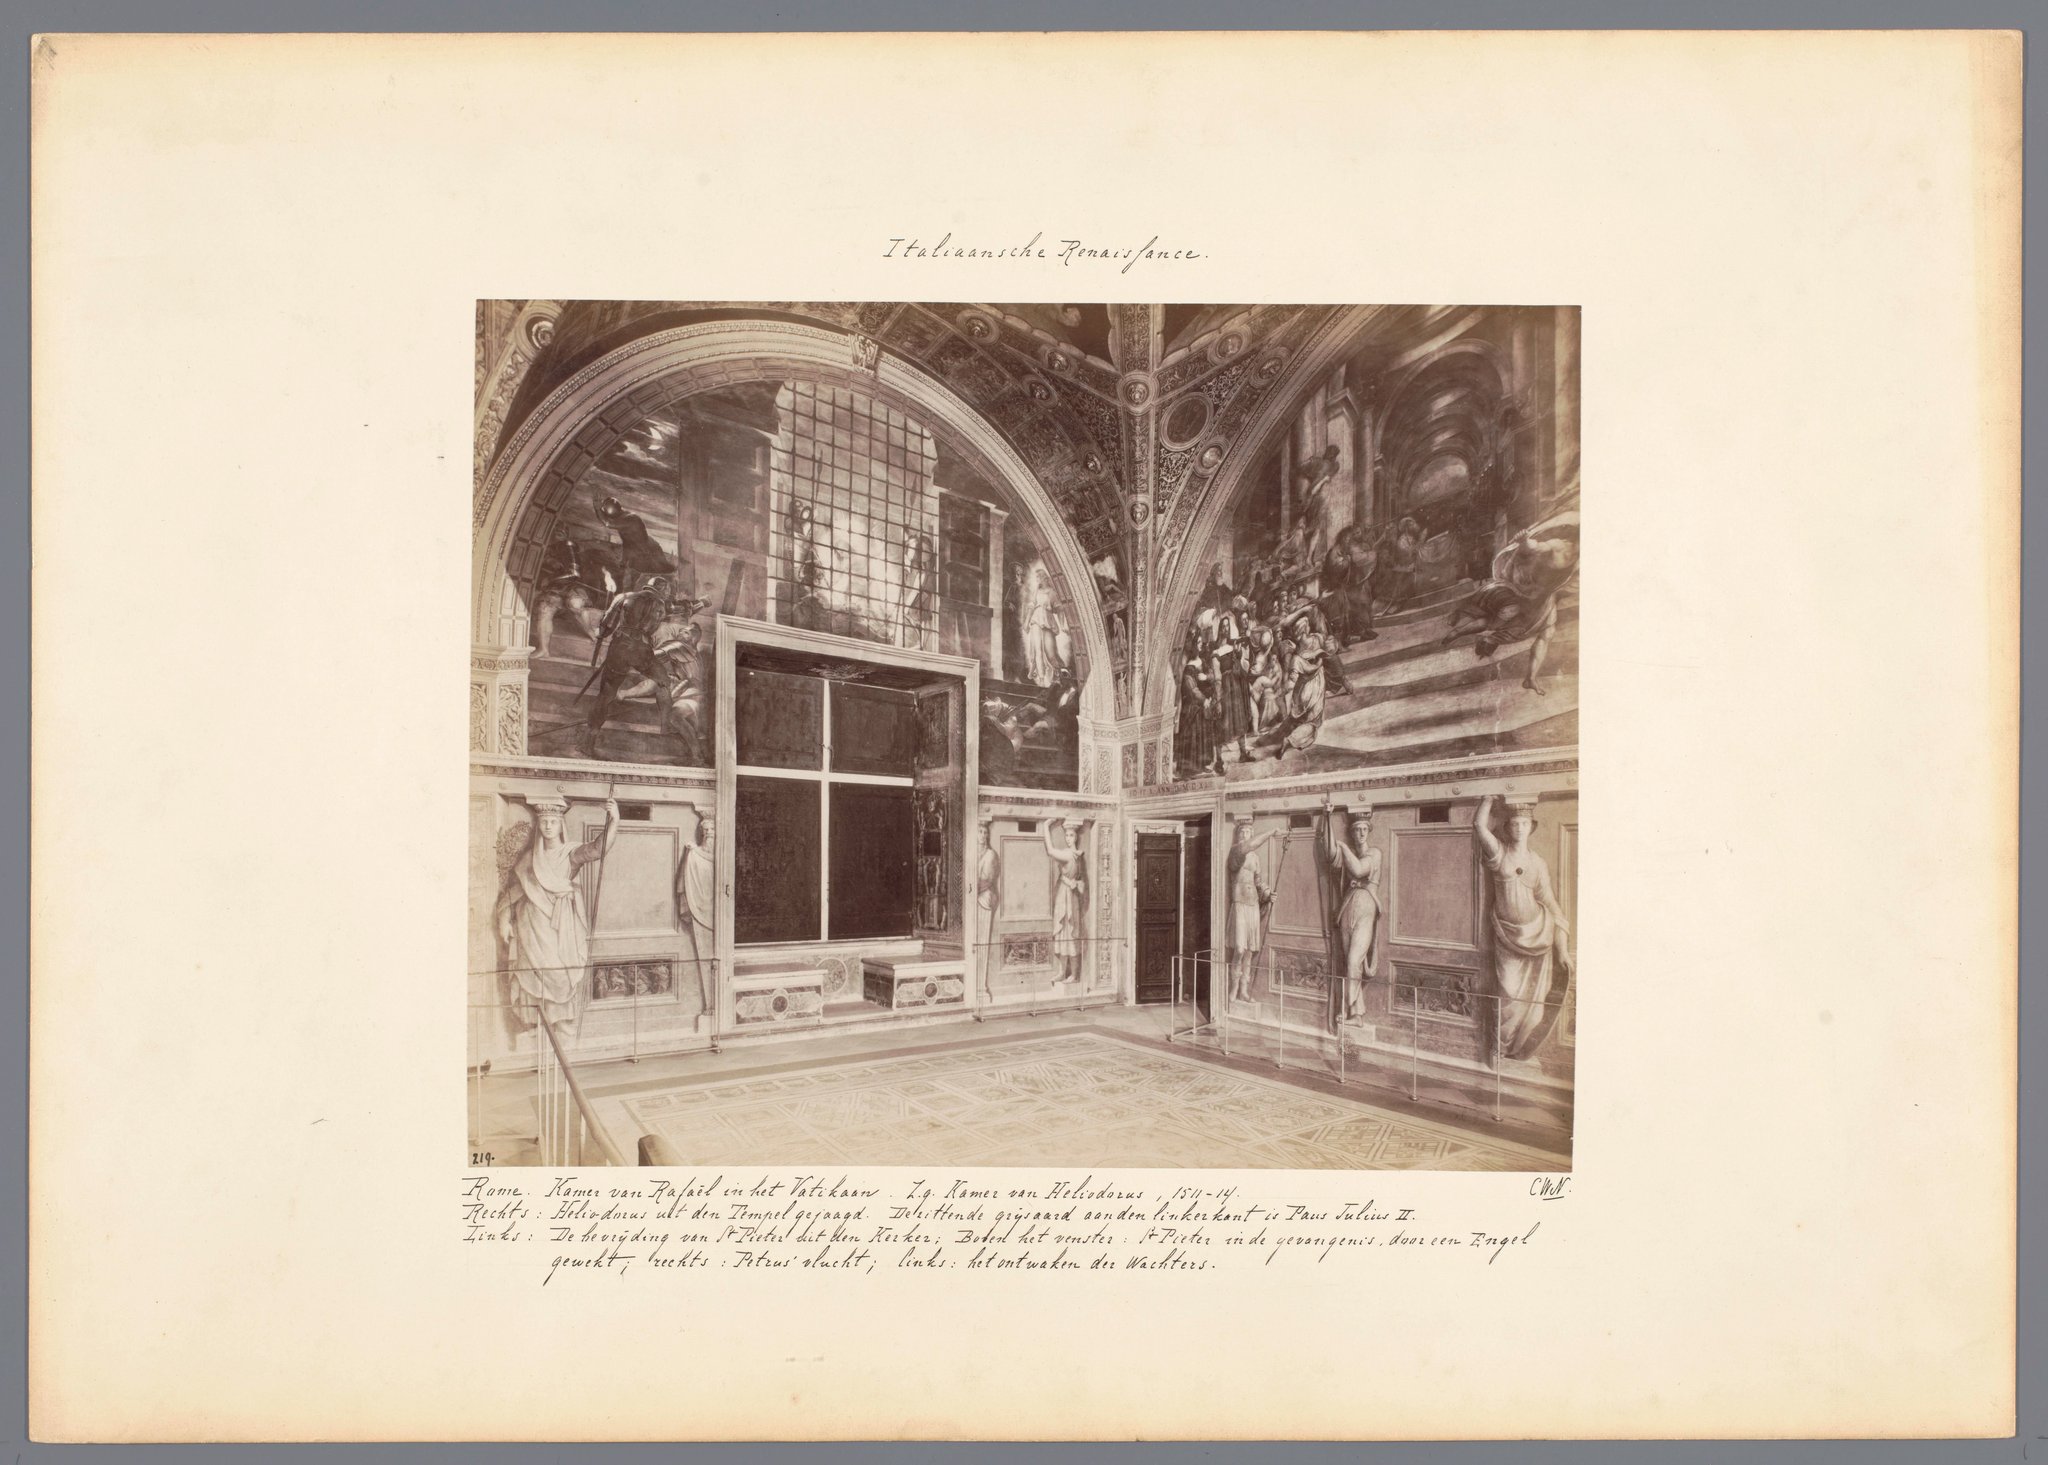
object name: photograph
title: Rome. Kamer van Rafaël in het Vatikaan . Z.g. Kamer van Heliodorus, 1511-14.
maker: Anonymous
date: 1875-1900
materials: cardboard, photographic support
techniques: albumen print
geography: vaticaan stanza d'eliodoro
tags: peter in prison ~ martyrdom and death of peter, palace, heliodorus in the temple, attacked by a man (or angel) on horseback and two other men (or angels) (2 maccabees 3:7-35)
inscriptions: collector's mark: ‘KUNSTNIJVERHEIDSCHOOL QUELLINUS AMSTERDAM FRANS HALSSTRAAT 14.’, inscription: ‘CWN.’, number: ‘219.’, collector's mark: ‘INSTITUUT VOOR KUNST-NIJVERHEIDSONDERWIJS GABRIËL METSUSTRAAT No. 16 AMSTERDAM’, inscription: ‘Italiaansche Renaissance.’